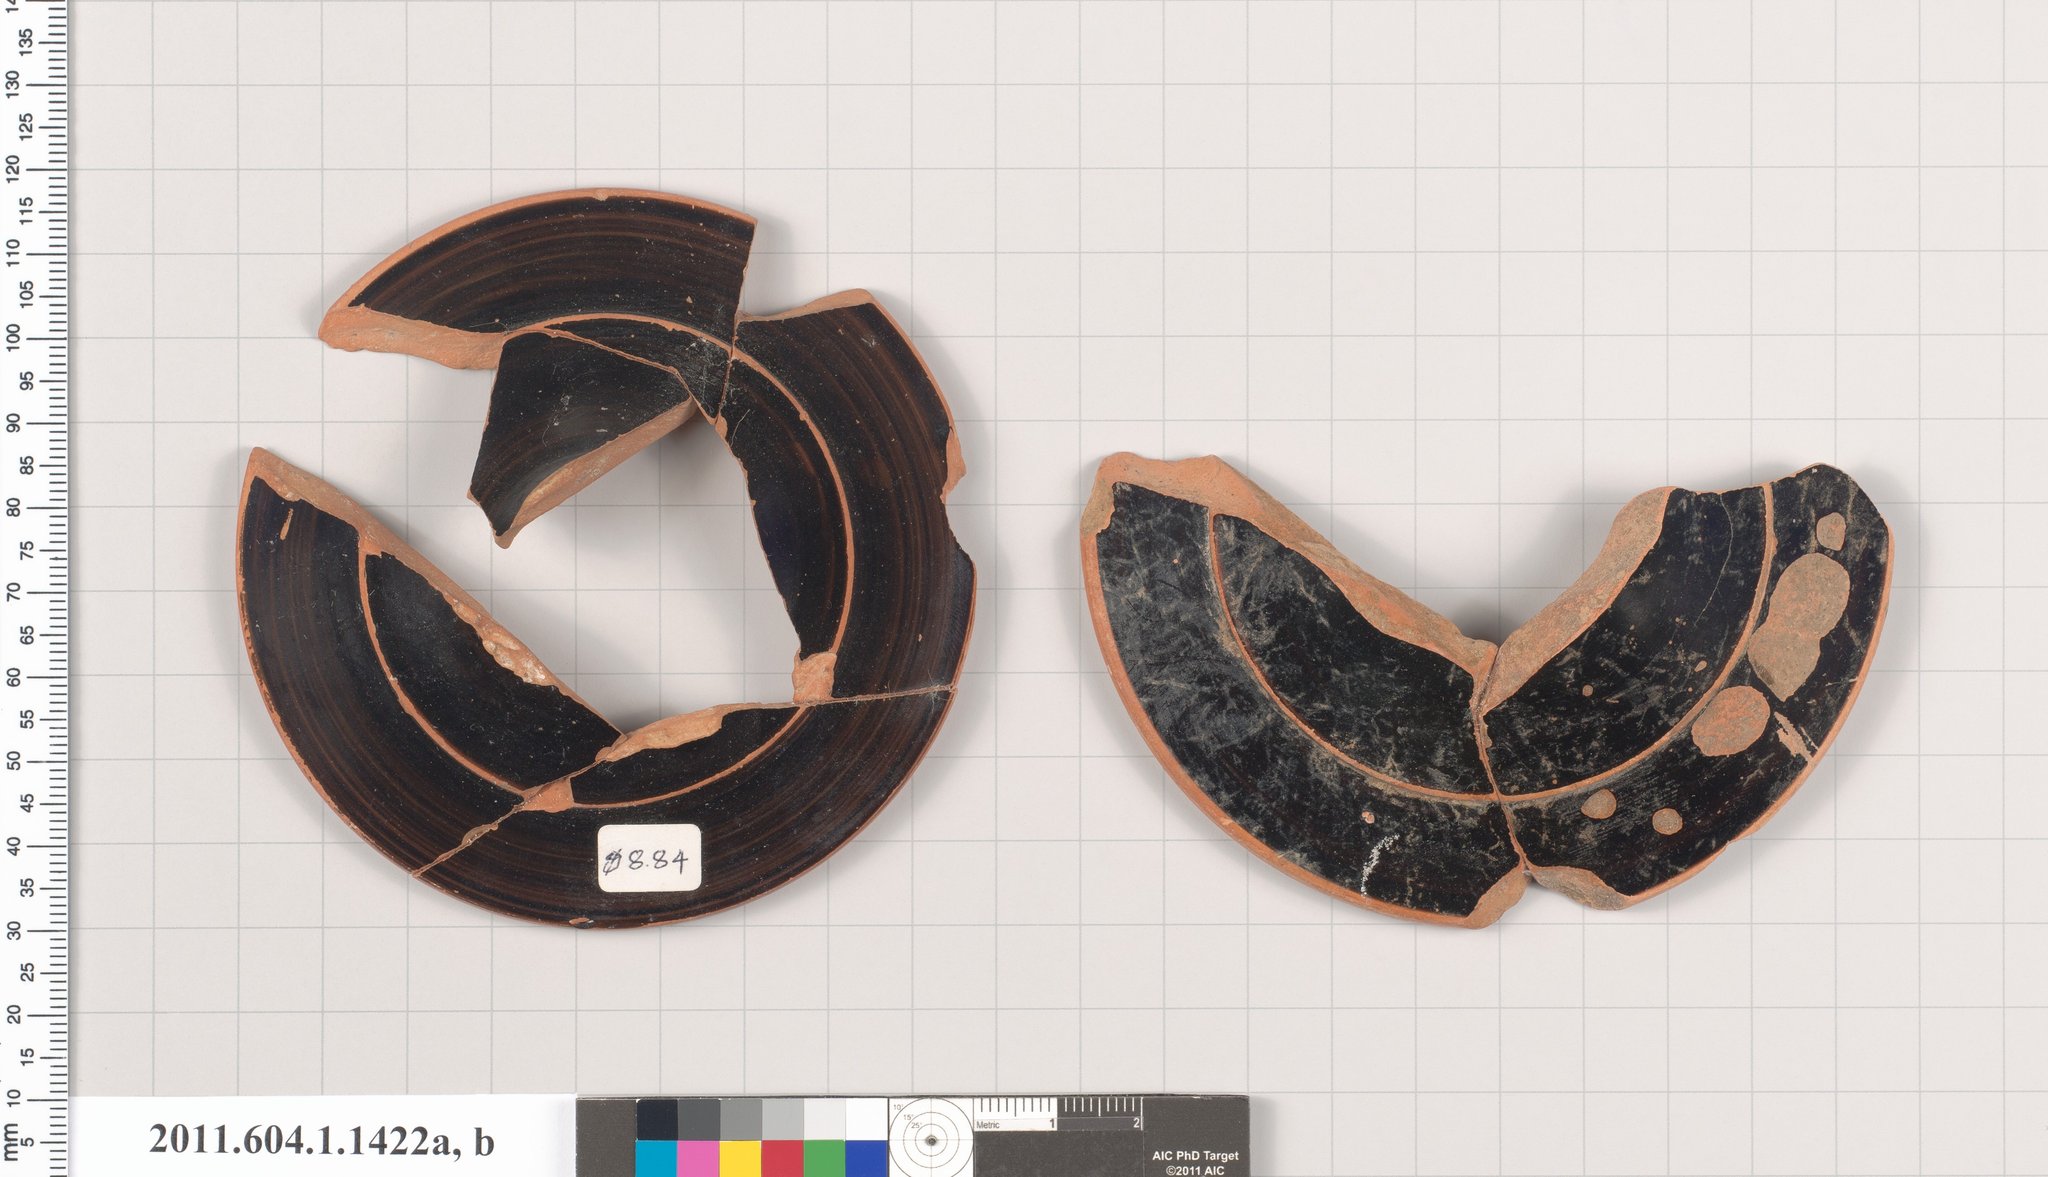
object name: kylix fragment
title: Terracotta fragments of kylikes (drinking cups)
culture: greek, attic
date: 500-401 BCE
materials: terracotta